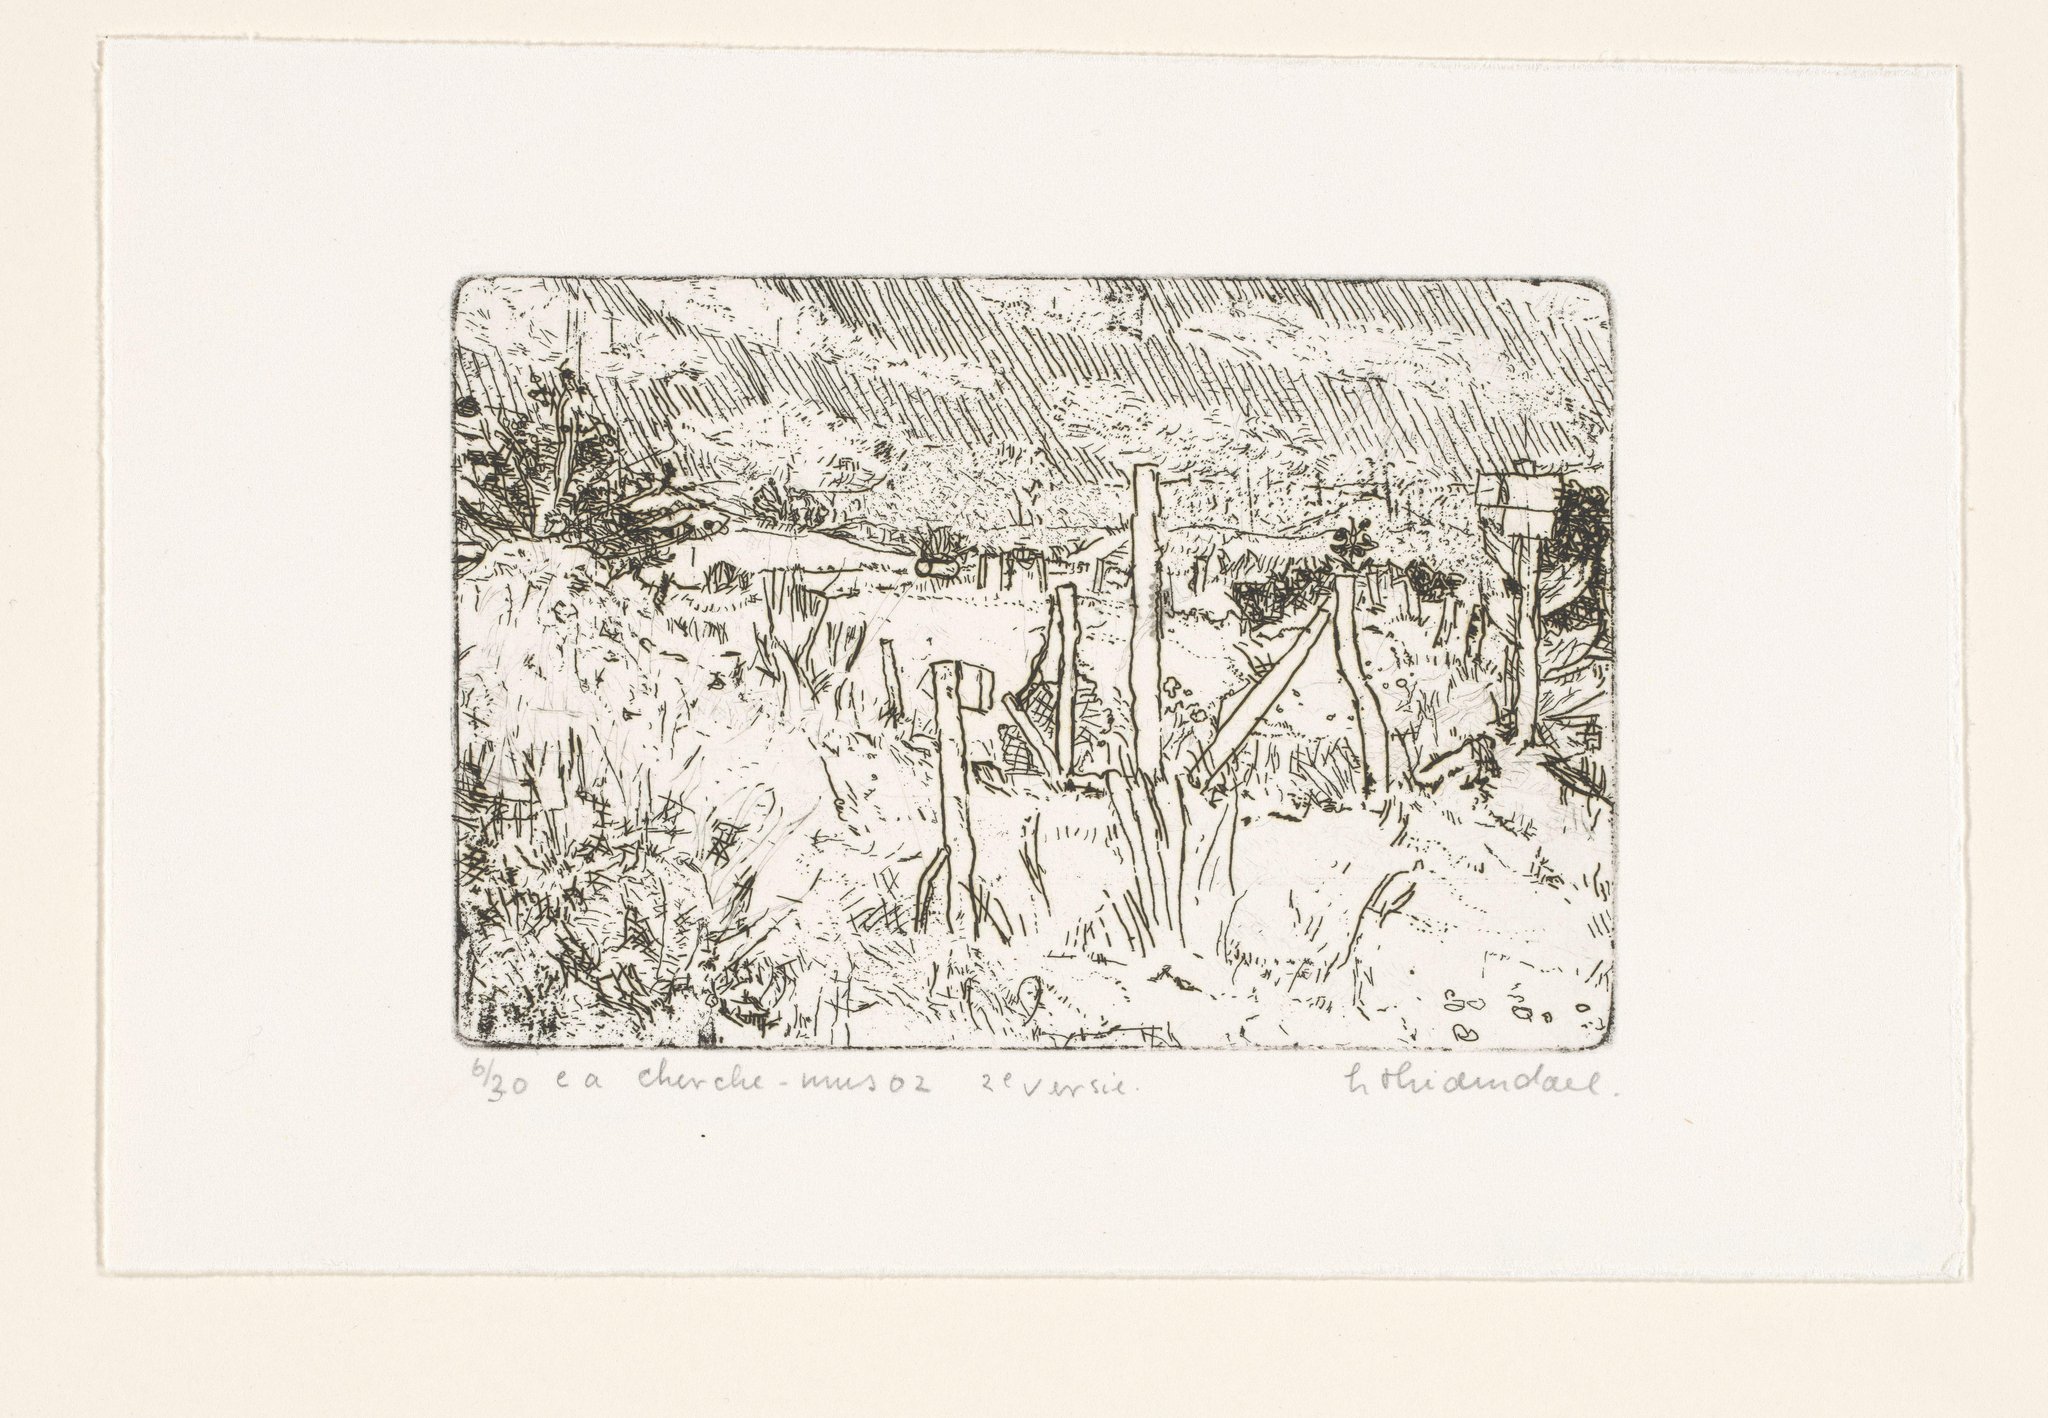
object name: print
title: Cherche muse (tweede versie)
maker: lau heidendael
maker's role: print maker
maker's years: 1946-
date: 2002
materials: paper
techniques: etching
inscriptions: inscription: ‘6/30 e a cherche mus 02 2e versie L Heidendael’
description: Landschap vol met palen en bewegwijzering.